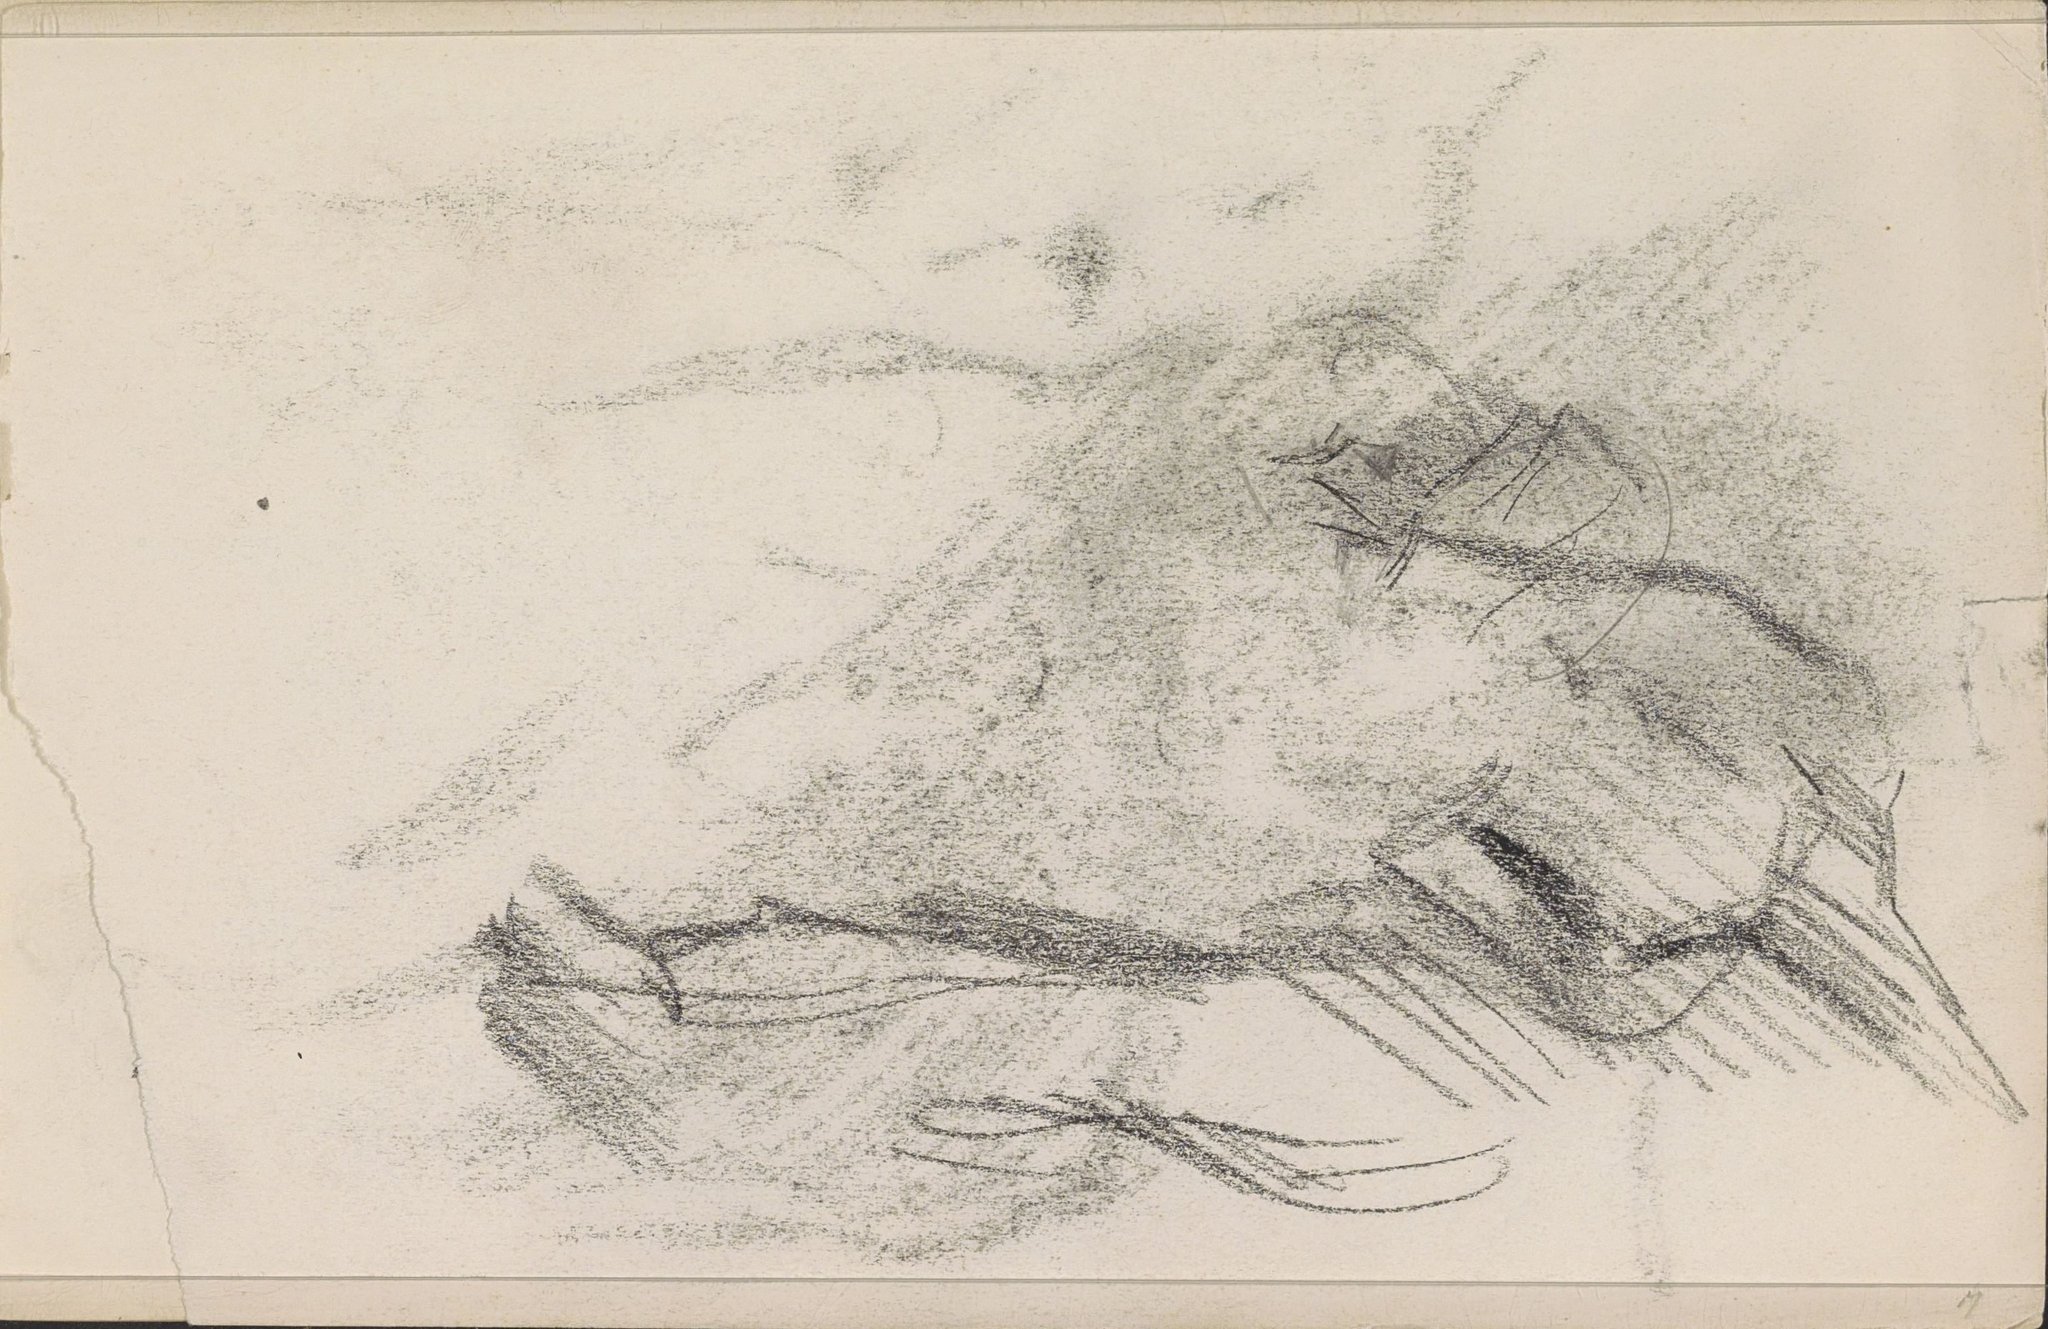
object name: sketchbook leaf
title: Studie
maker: isaac israels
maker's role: draughtsman, painter, print maker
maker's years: 1865-1934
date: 1875-1934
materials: chalk, paper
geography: paris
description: Blad 7 recto uit schetsboek LI met 11 bladen.